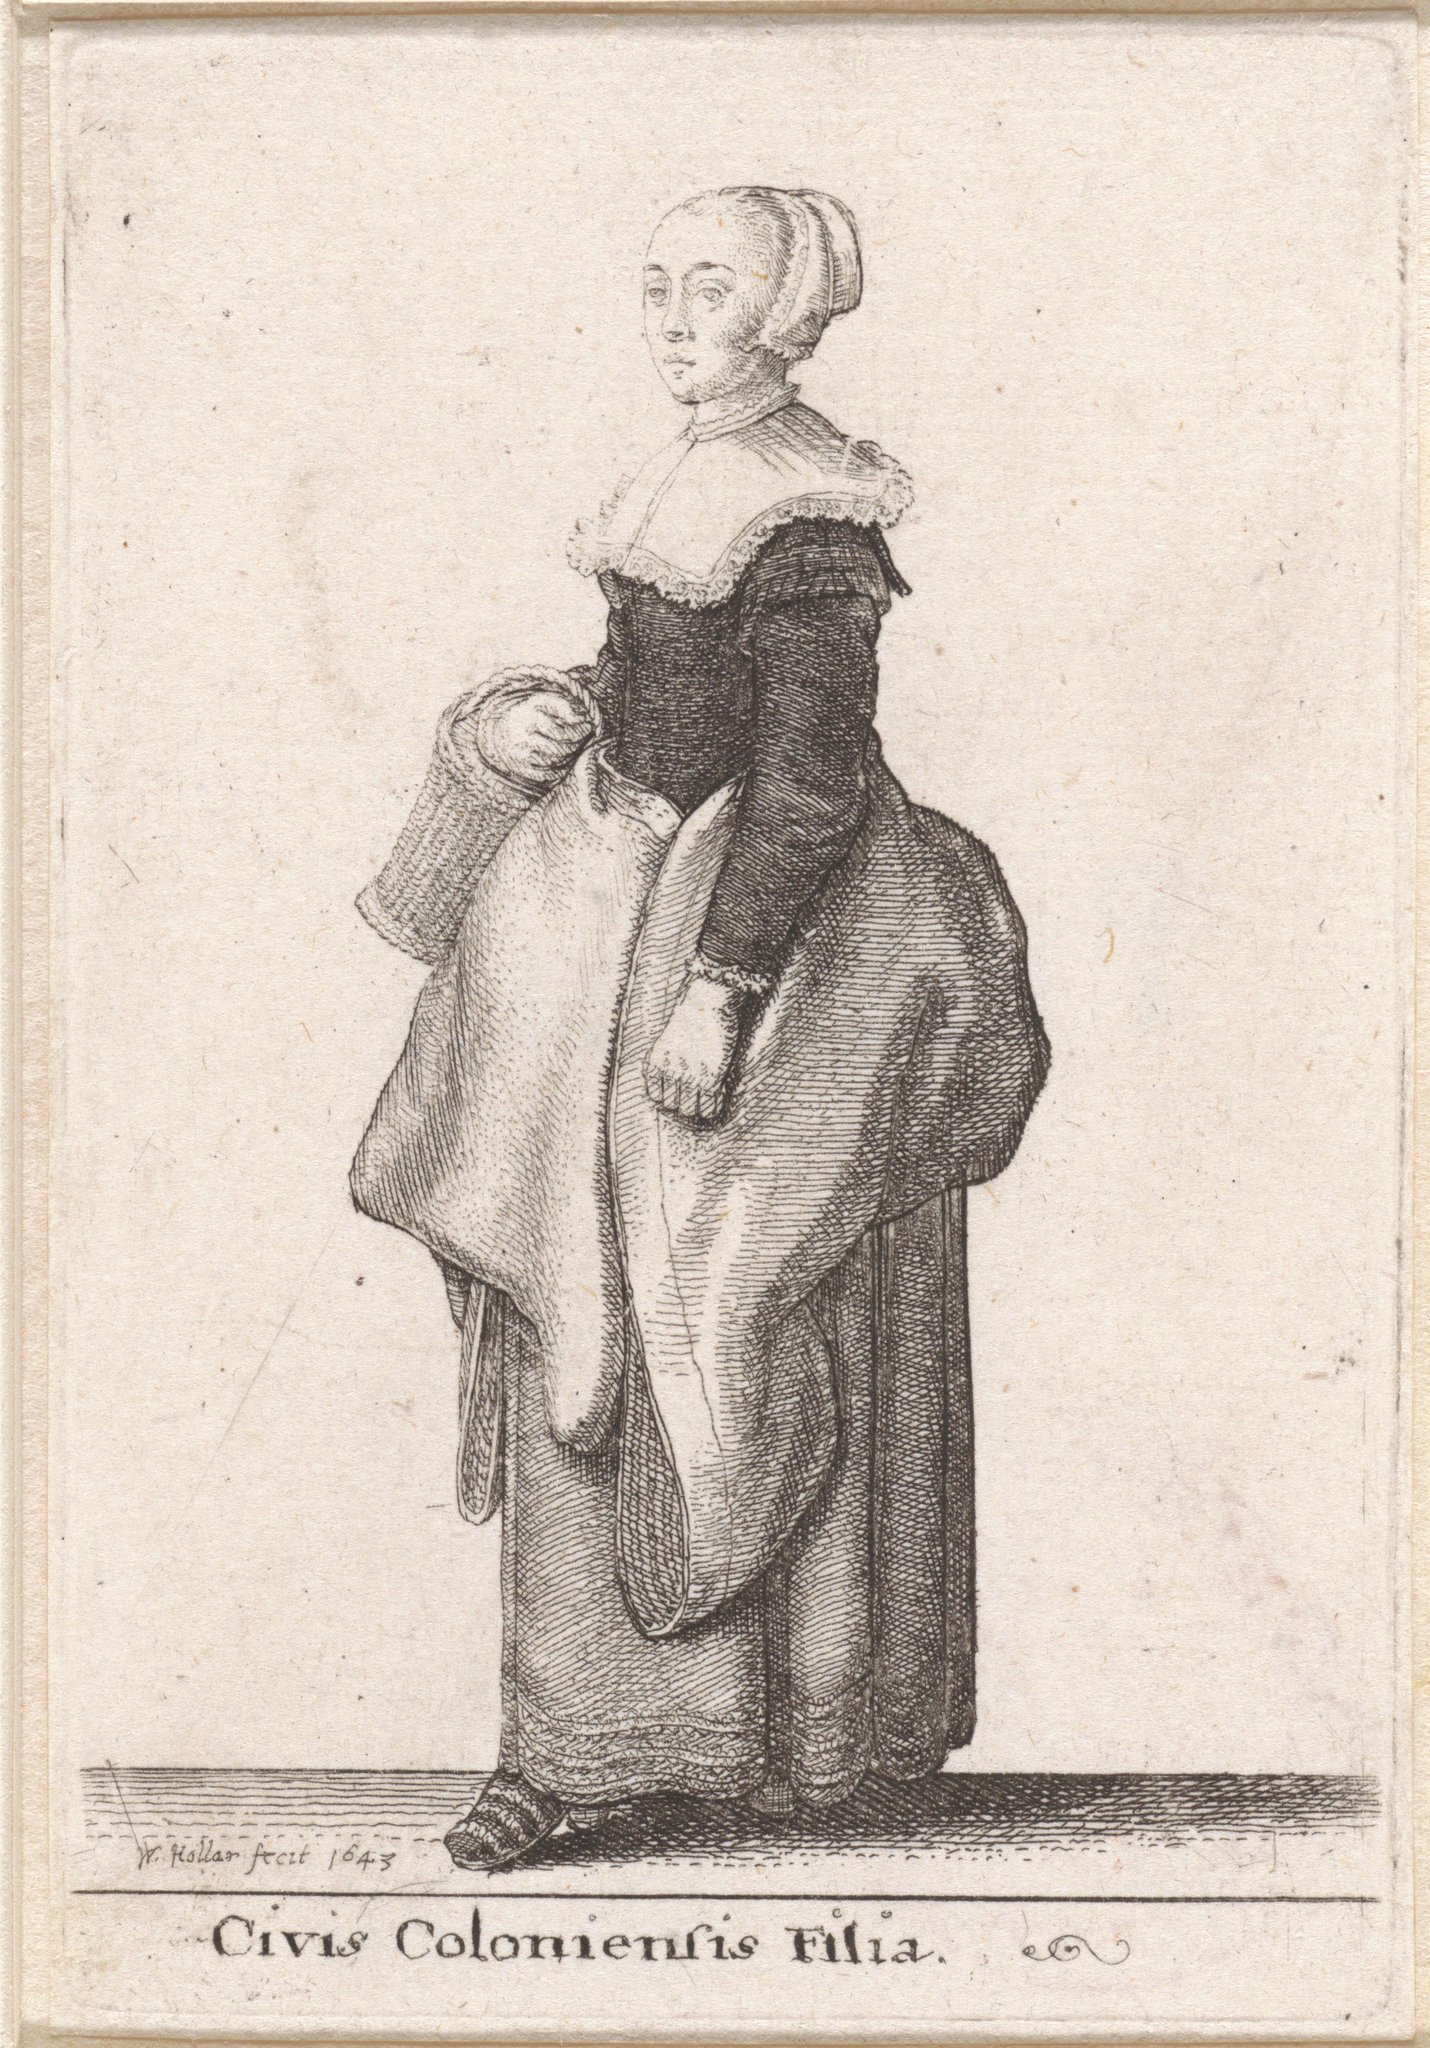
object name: costume print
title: Europese klederdrachten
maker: wenceslaus hollar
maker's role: draughtsman, print maker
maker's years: 1607-1677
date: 1643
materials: paper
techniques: etching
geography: london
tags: head-gear: cap (+ women's clothes), carrying something in basket, bag, rucksack, etc., container made of plant material other than wood: basket, cologne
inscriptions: collector's mark: Lugt 240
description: Dienstmeisje uit Keulen, een wit mutsje op het hoofd, hoog gesloten kraag afgezet met kant op een donker lijfje. De bovenrok is opgeschort, zodat een groot deel van de onderrok zichtbaar is. Een rieten mand aan de rechterarm.